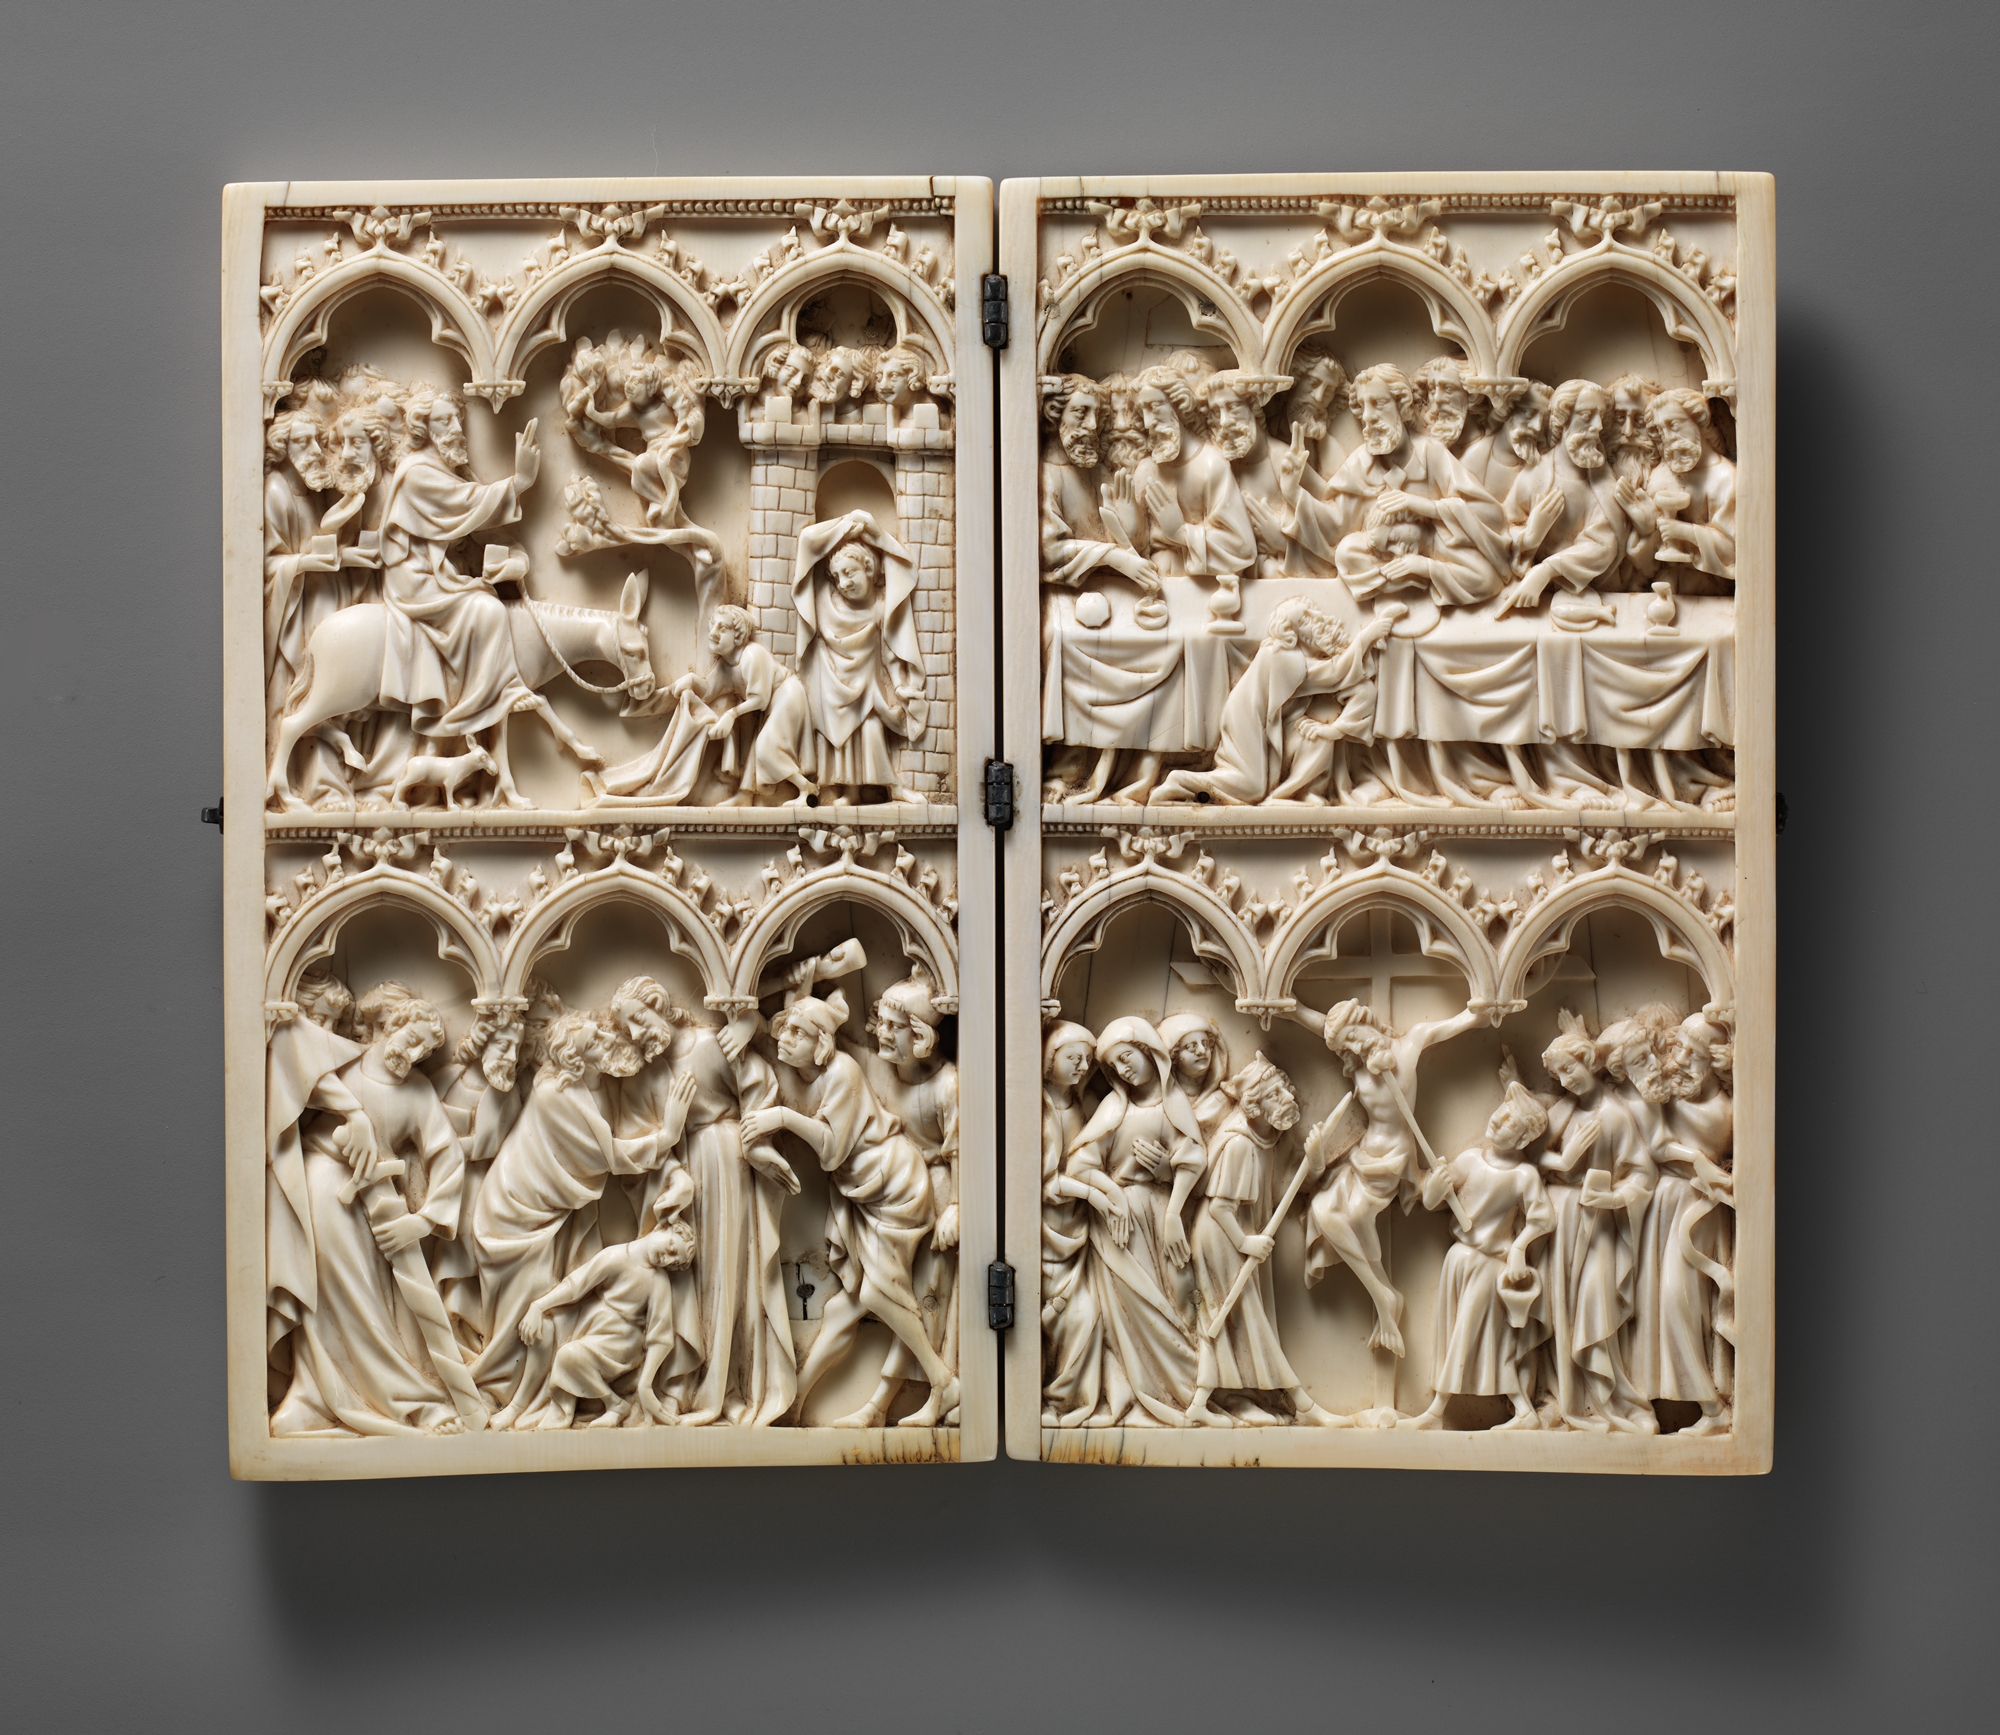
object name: diptych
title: Diptych with Scenes from the Passion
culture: french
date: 1350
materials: ivory, metal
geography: france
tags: donkeys,christ,virgin mary,judas,crucifixion,last supper